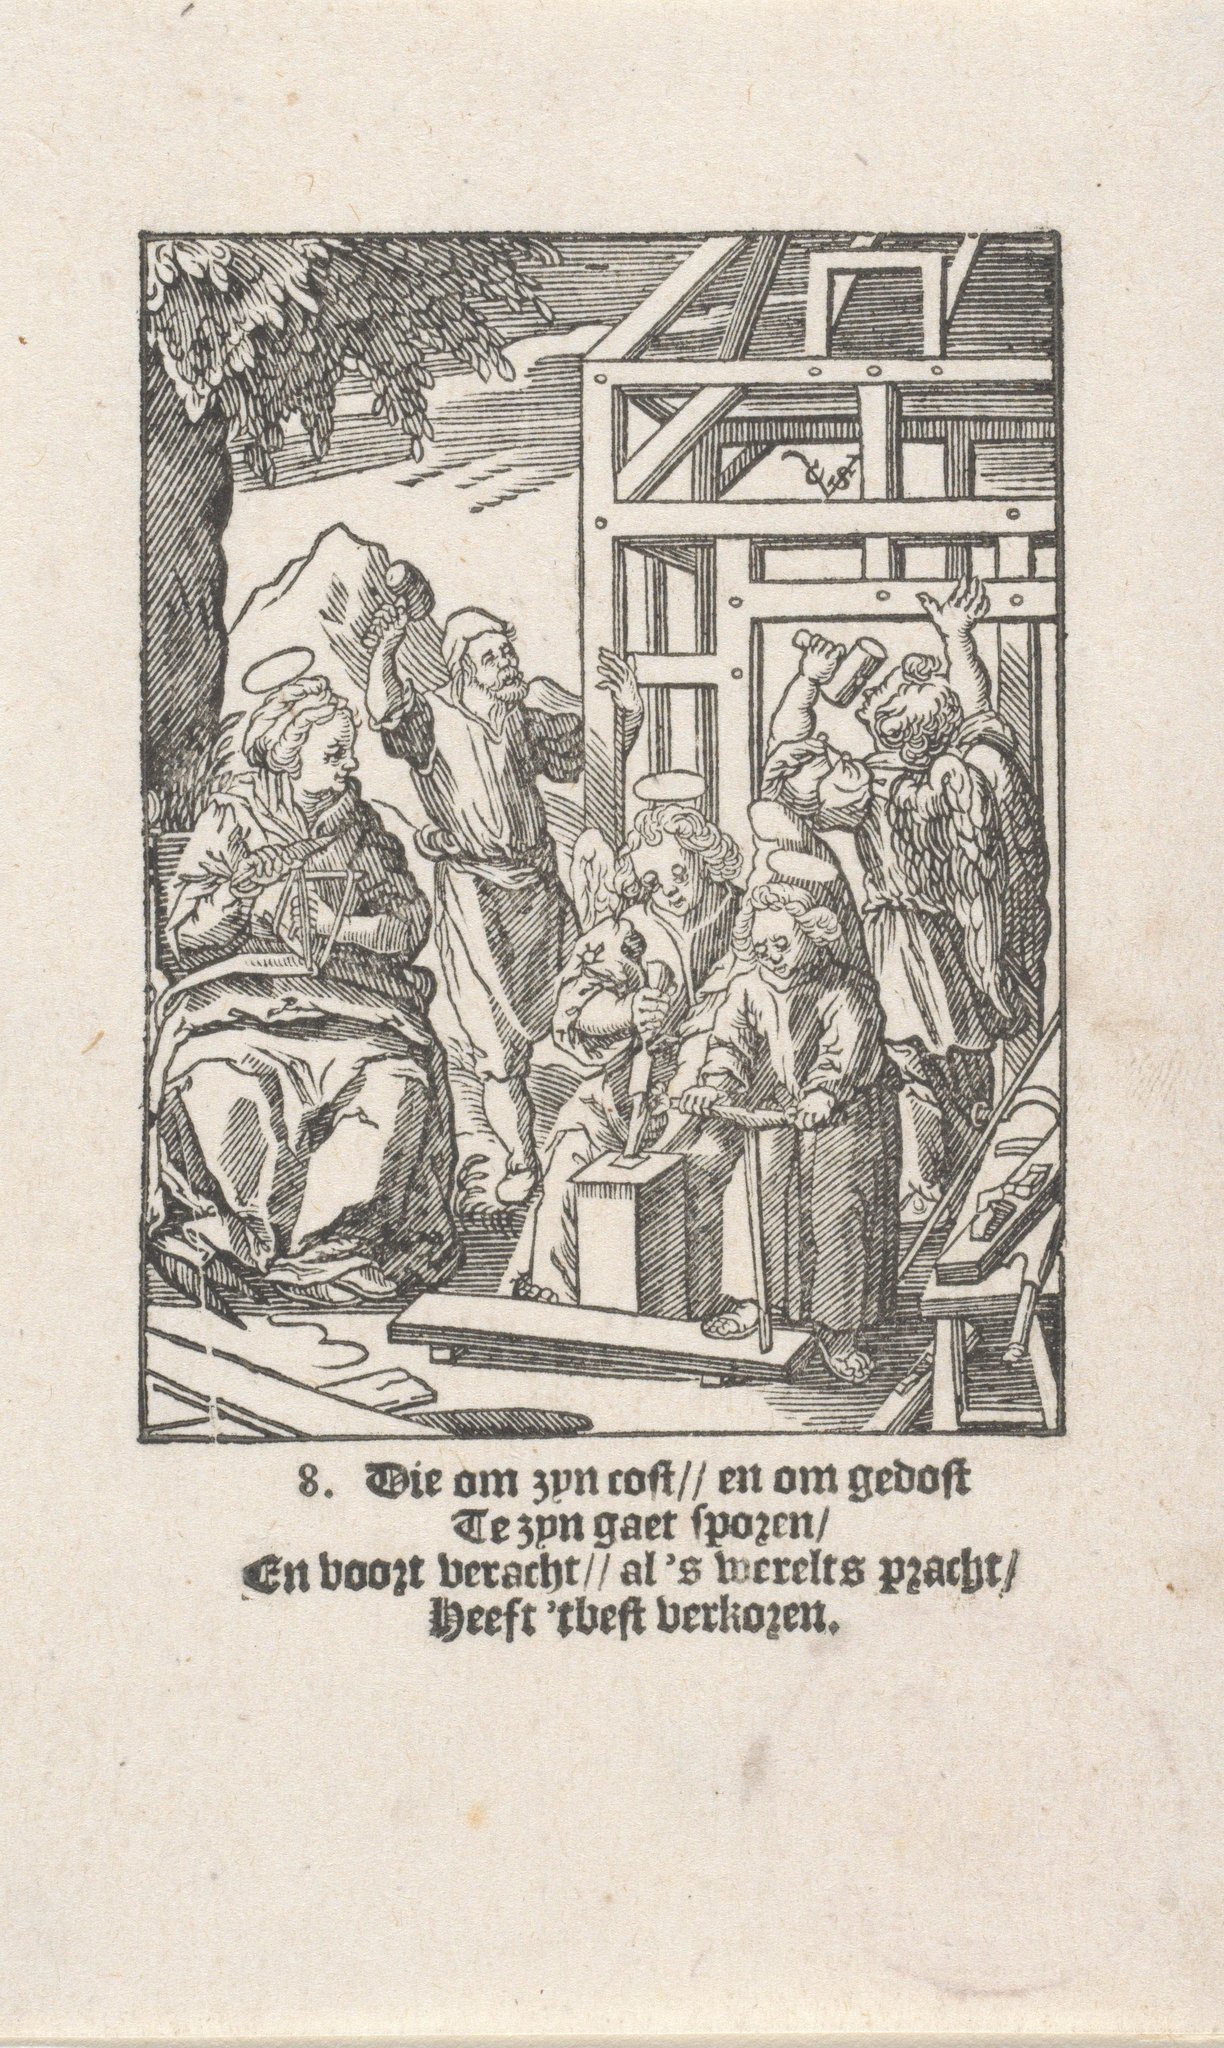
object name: print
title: De kindsheyd onses heeren Iesu Christi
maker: christoffel van sichem (ii)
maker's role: print maker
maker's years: 1581-1658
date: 1617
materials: paper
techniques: letterpress printing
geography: amsterdam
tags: joseph and the christ-child ~ daily life in nazareth, angels, household occupations of mary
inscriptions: collector's mark: Lugt 240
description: Het Christuskind boort een gat in een plank. Samen met twee engelen en Jozef bouwt hij een huis. Maria kijkt toe terwijl ze bezig is met een klos garen. In de ondermarge vier regels Nederlandse tekst.